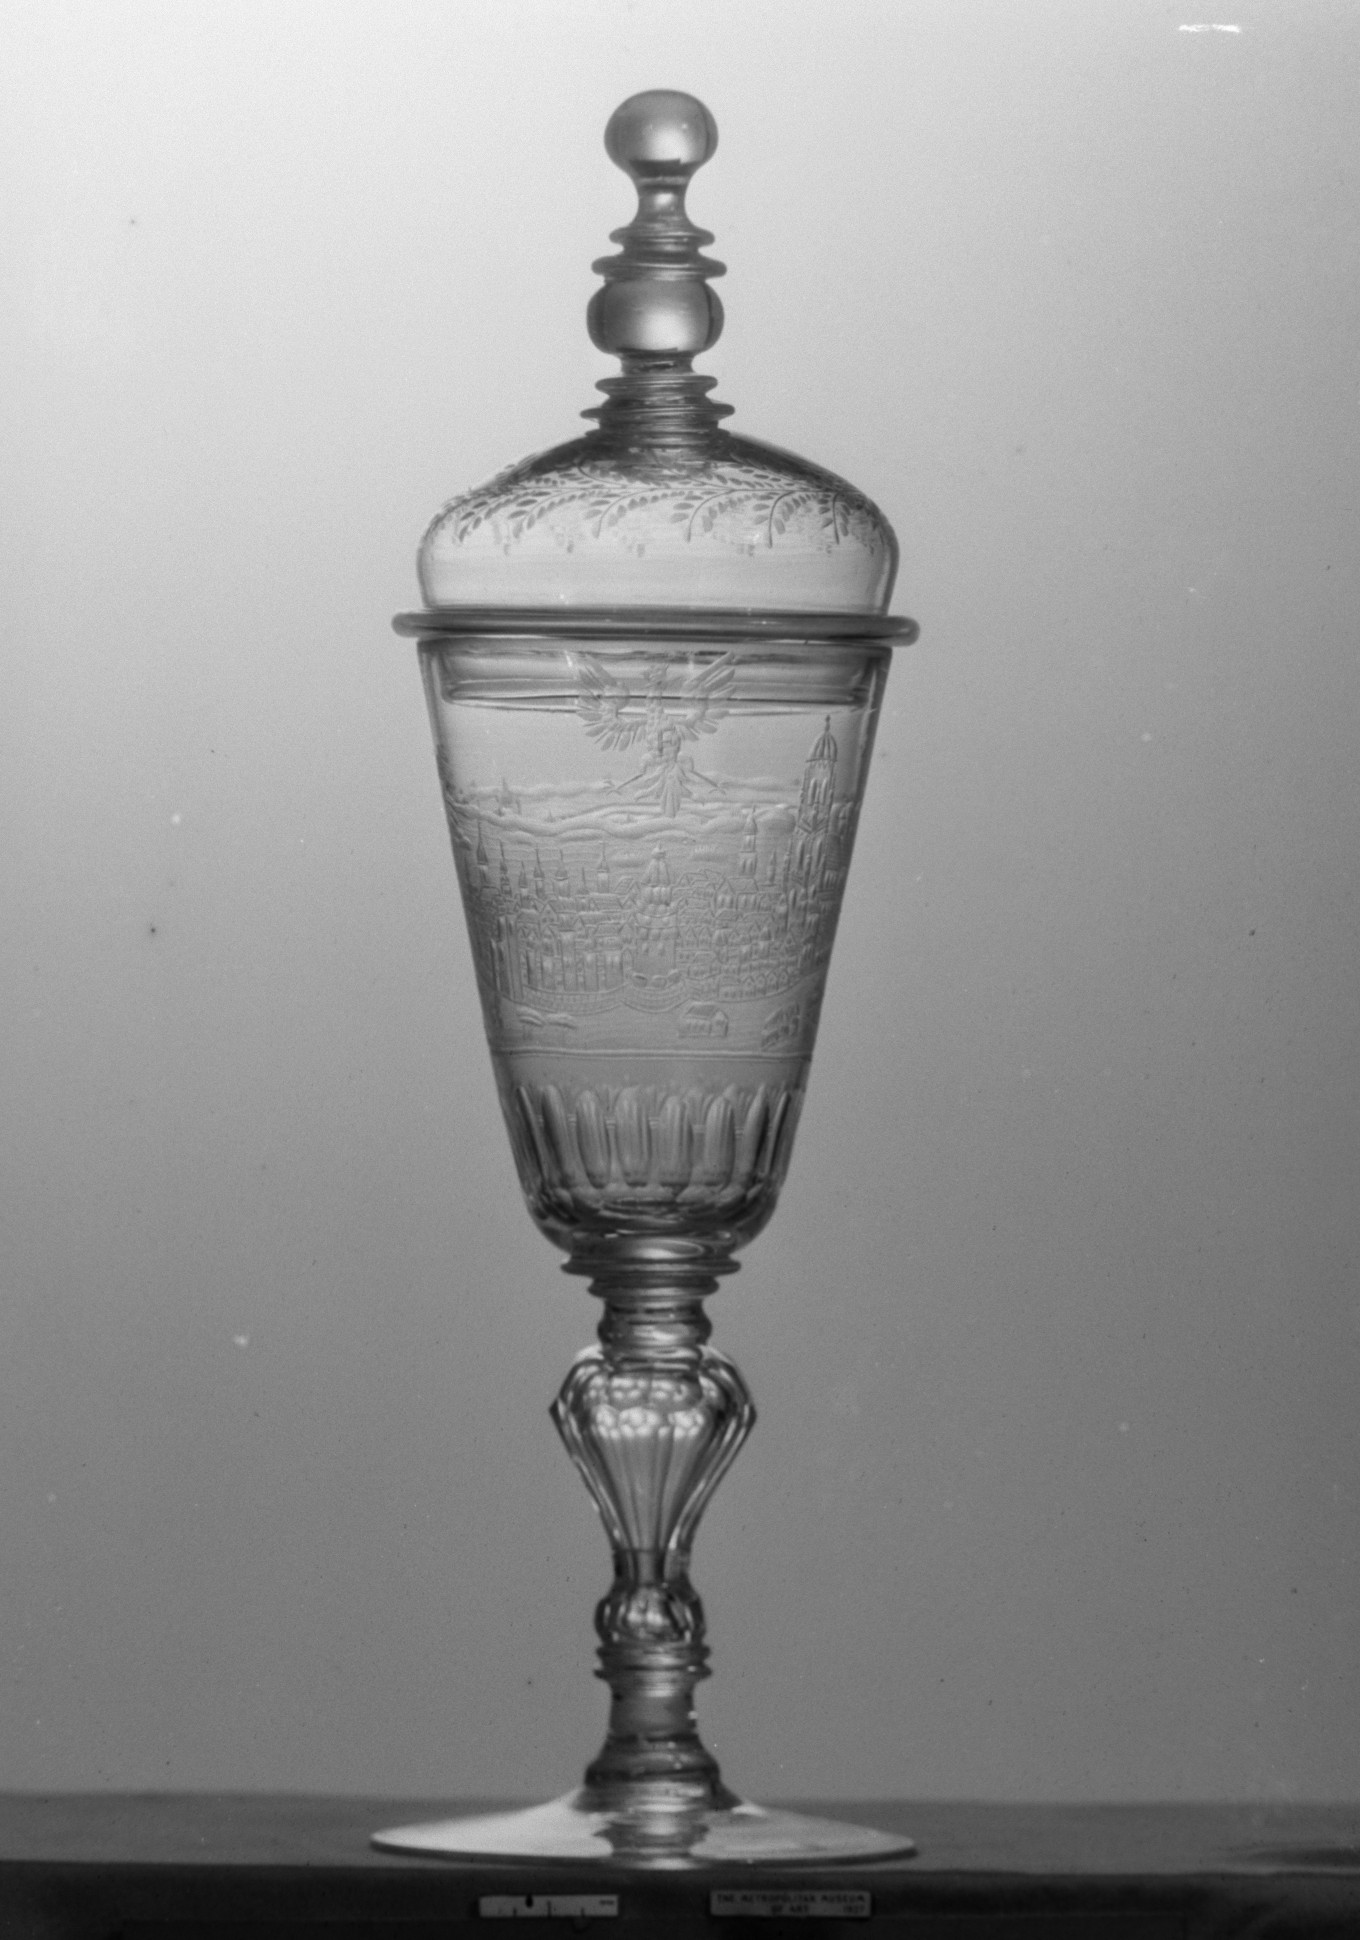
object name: standing cup with cover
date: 1734-1766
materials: glass